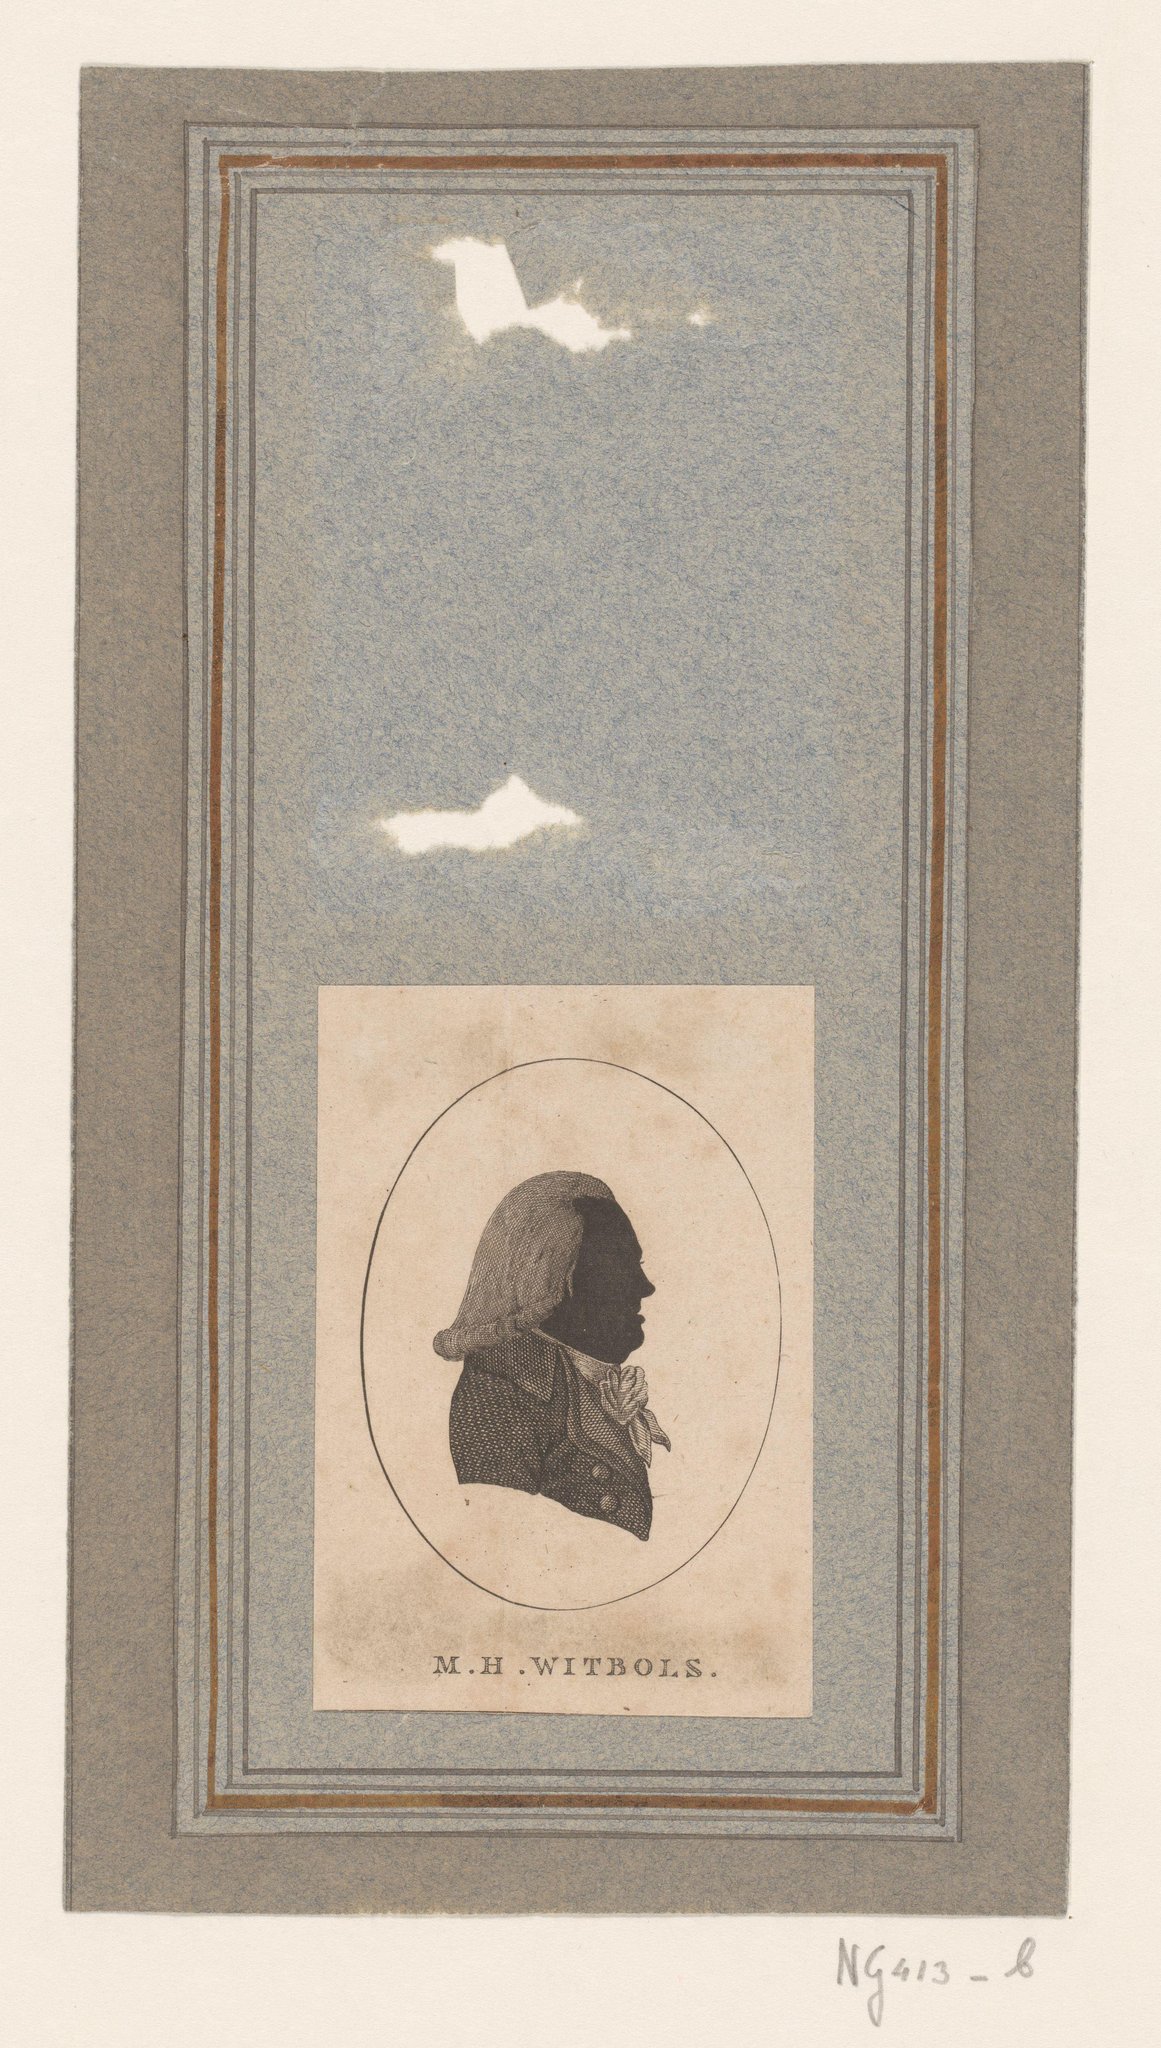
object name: print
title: Portret van M.H. Witbols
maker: antoni zürcher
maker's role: print maker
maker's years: 1754-1837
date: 1796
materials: paper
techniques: etching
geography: netherlands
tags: rotterdam, historical persons (+ profile portrait), the hague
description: Portret in silhouet van Michaël Henricus Witbols, naar rechts, borstbeeld, met pruik en strikdas in een ovaal kader.